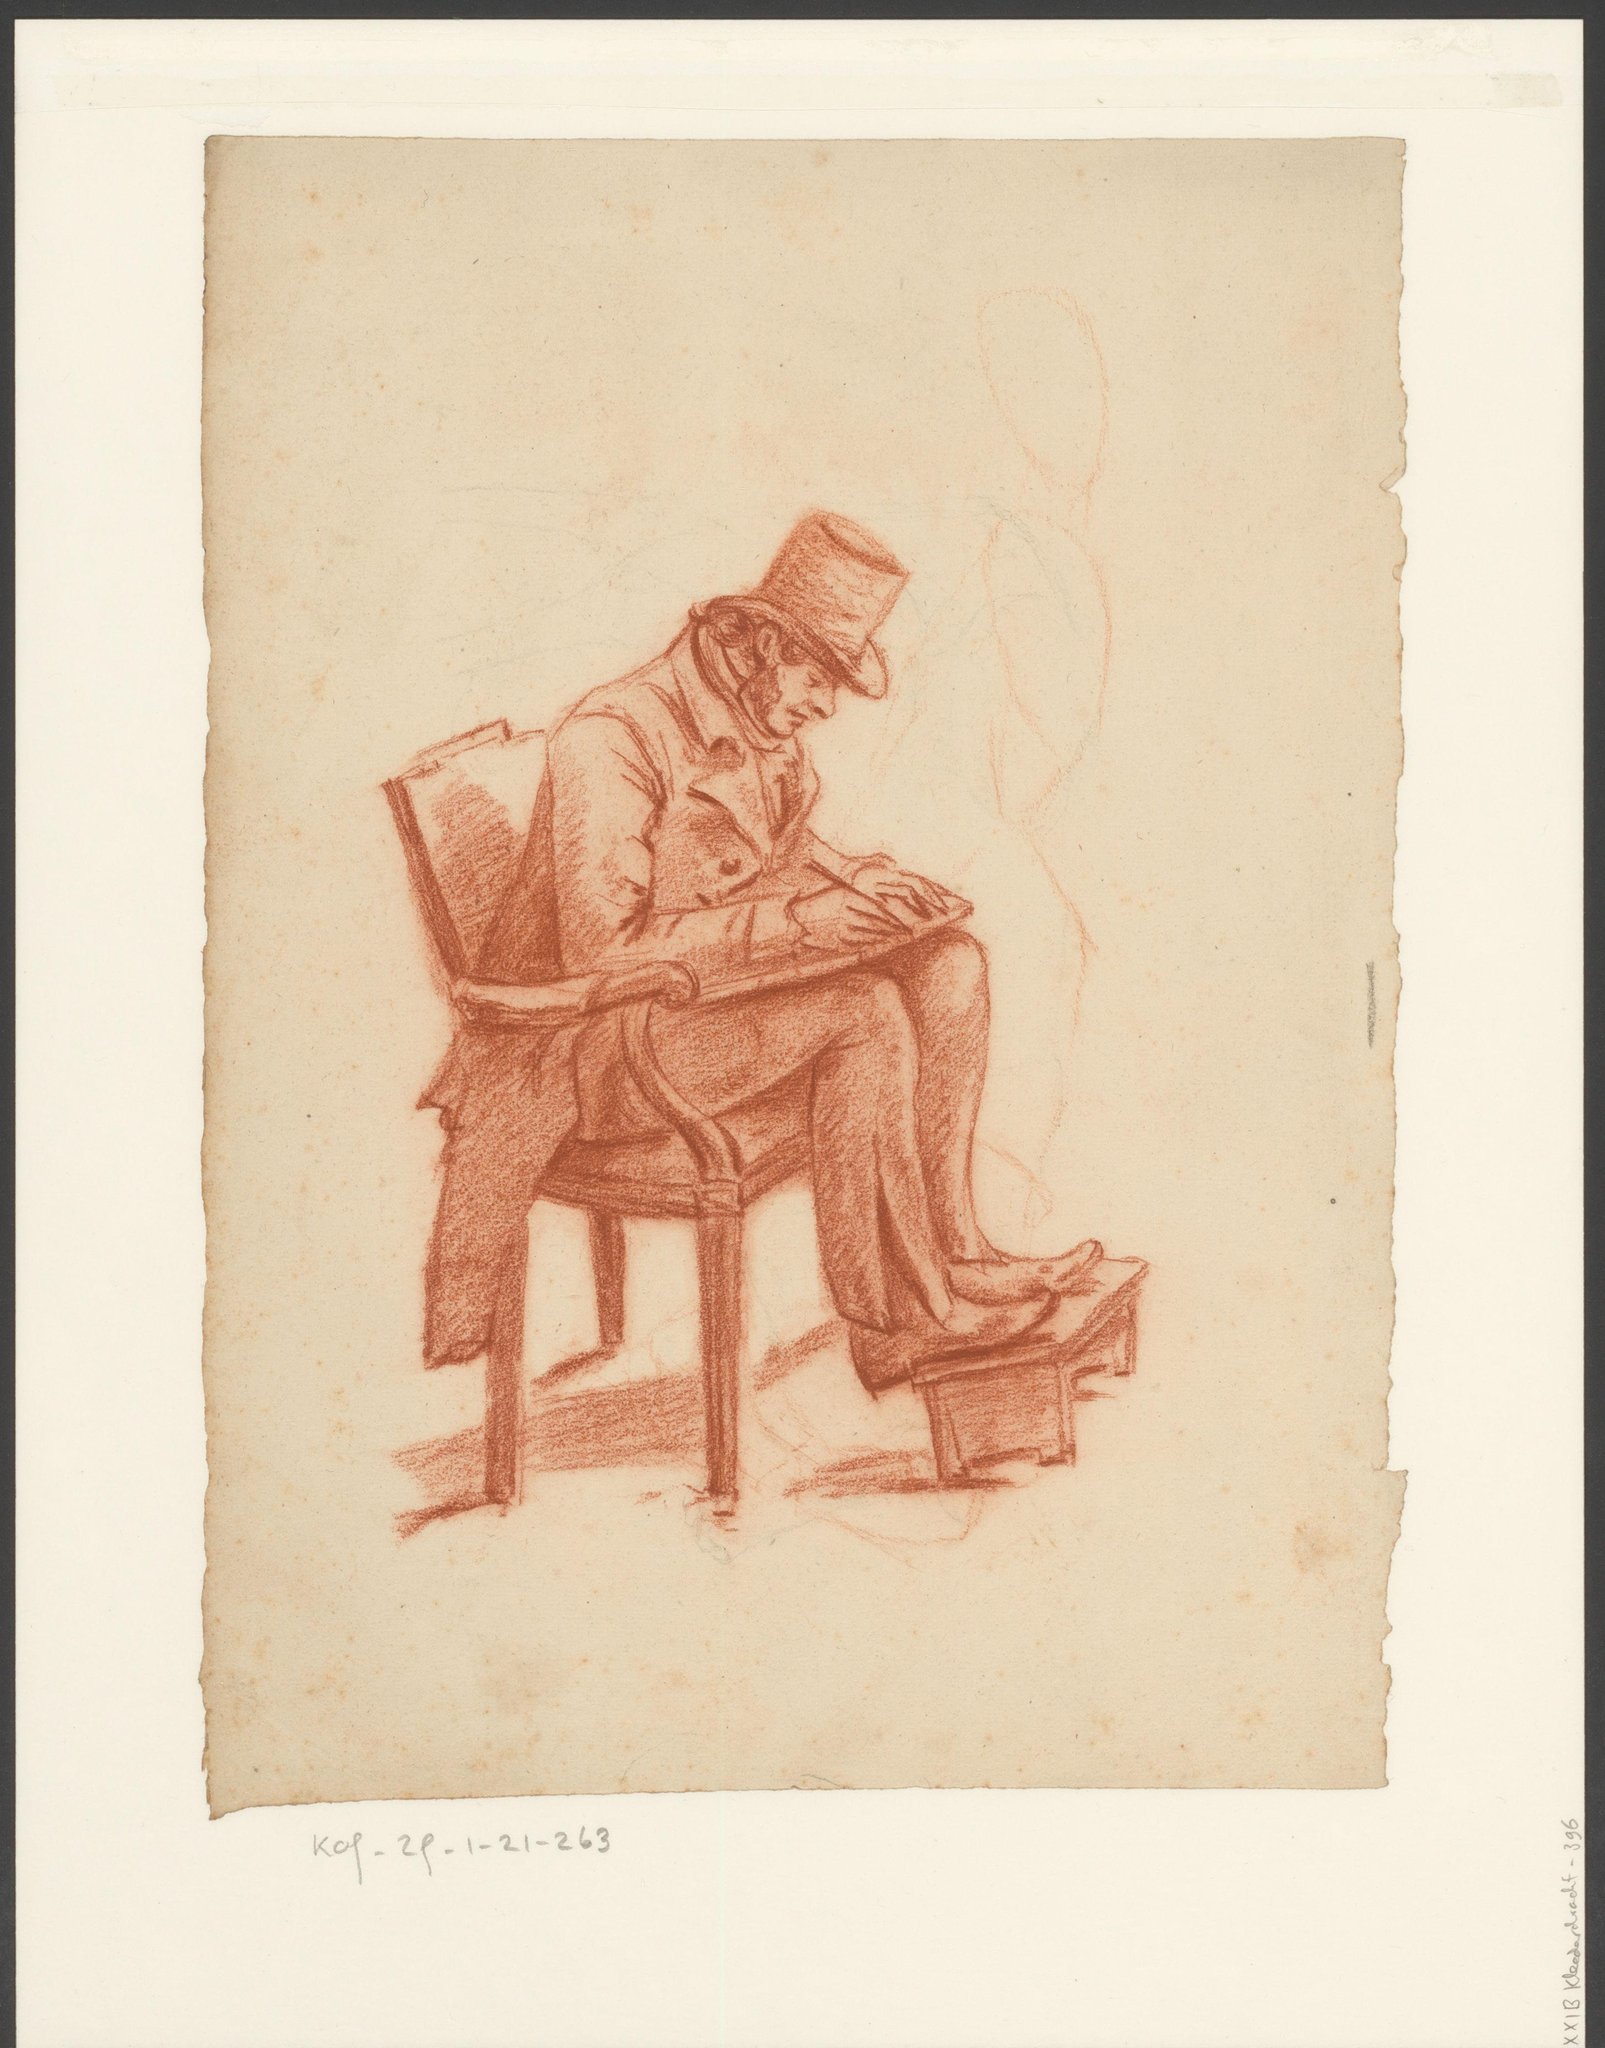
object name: drawing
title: Tekenende man met voeten op een stoof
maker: jean bernard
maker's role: draughtsman, print maker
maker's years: 1765-1833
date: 1775-1833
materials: chalk, paper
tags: drawing, foot-stove, sitting on an elevation, head-gear: top hat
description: Onderwerpsrubrieken binnen de Atlas Zeden en Gewoonten: Zeden en Gewoonten in Engeren Zin, De Kleeding, Kleederdrachten (tijdvakken), De regeering van Willem I. Mannen en vrouwen.